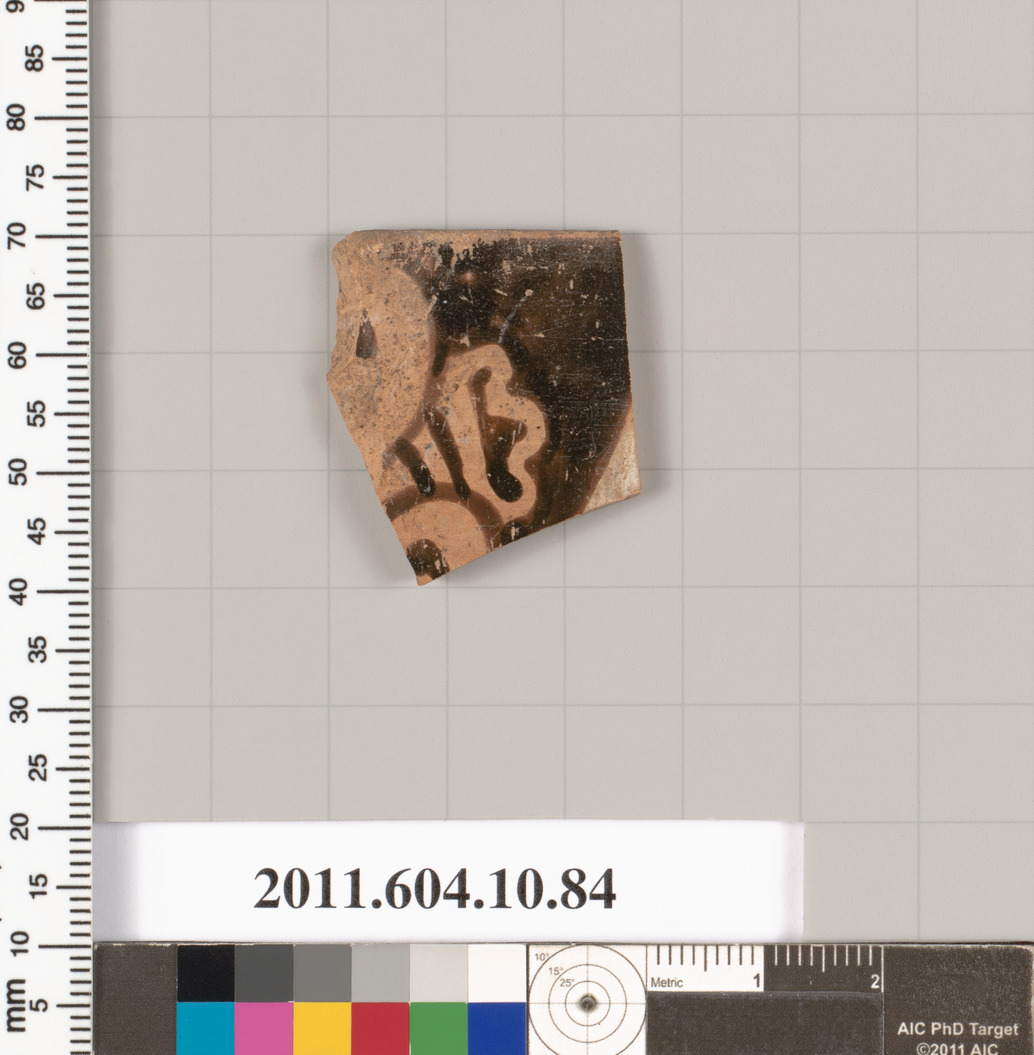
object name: skyphos fragment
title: Terracotta rim fragment of a skyphos (deep drinking cup)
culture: etruscan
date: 400-301 BCE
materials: terracotta